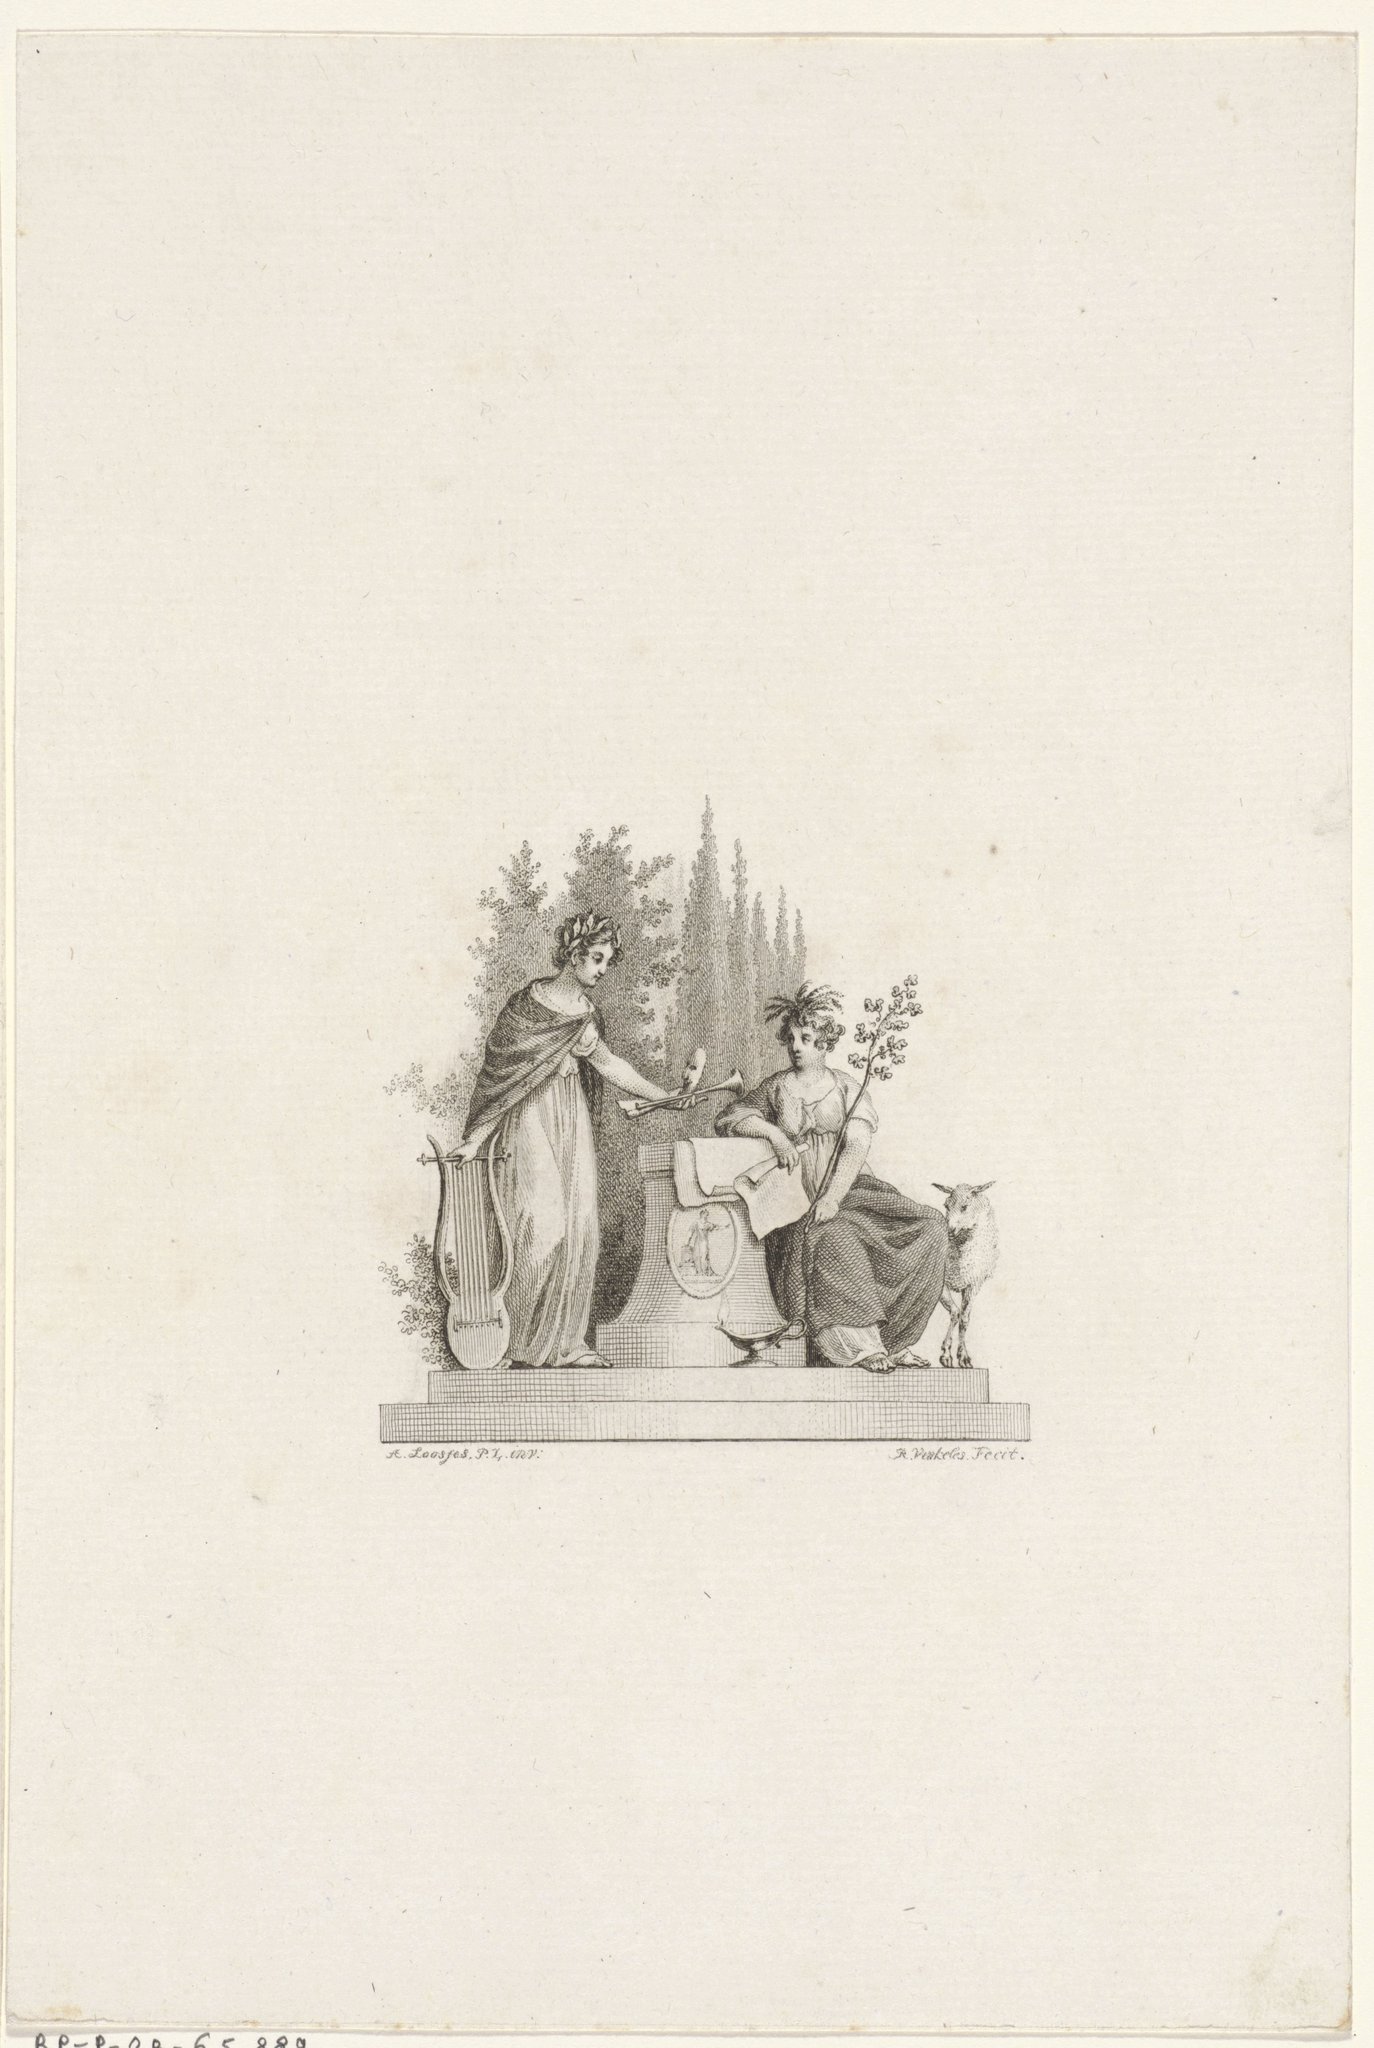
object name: print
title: Vrouw met een lier reikt een vrouw met een tak een bazuin en masker aan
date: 1771-1816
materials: paper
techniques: engraving, etching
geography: amsterdam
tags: mask, harp, oil-lamp, lamb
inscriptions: collector's mark: Lugt 2228